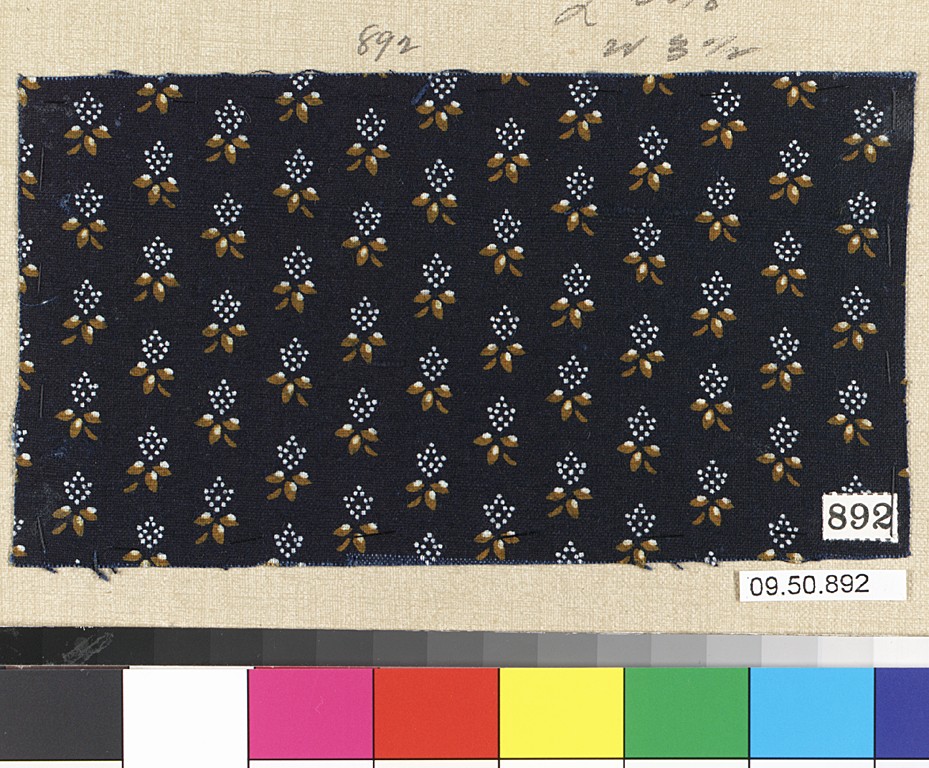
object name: piece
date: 1801-1900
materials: cotton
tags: flowers,leaves